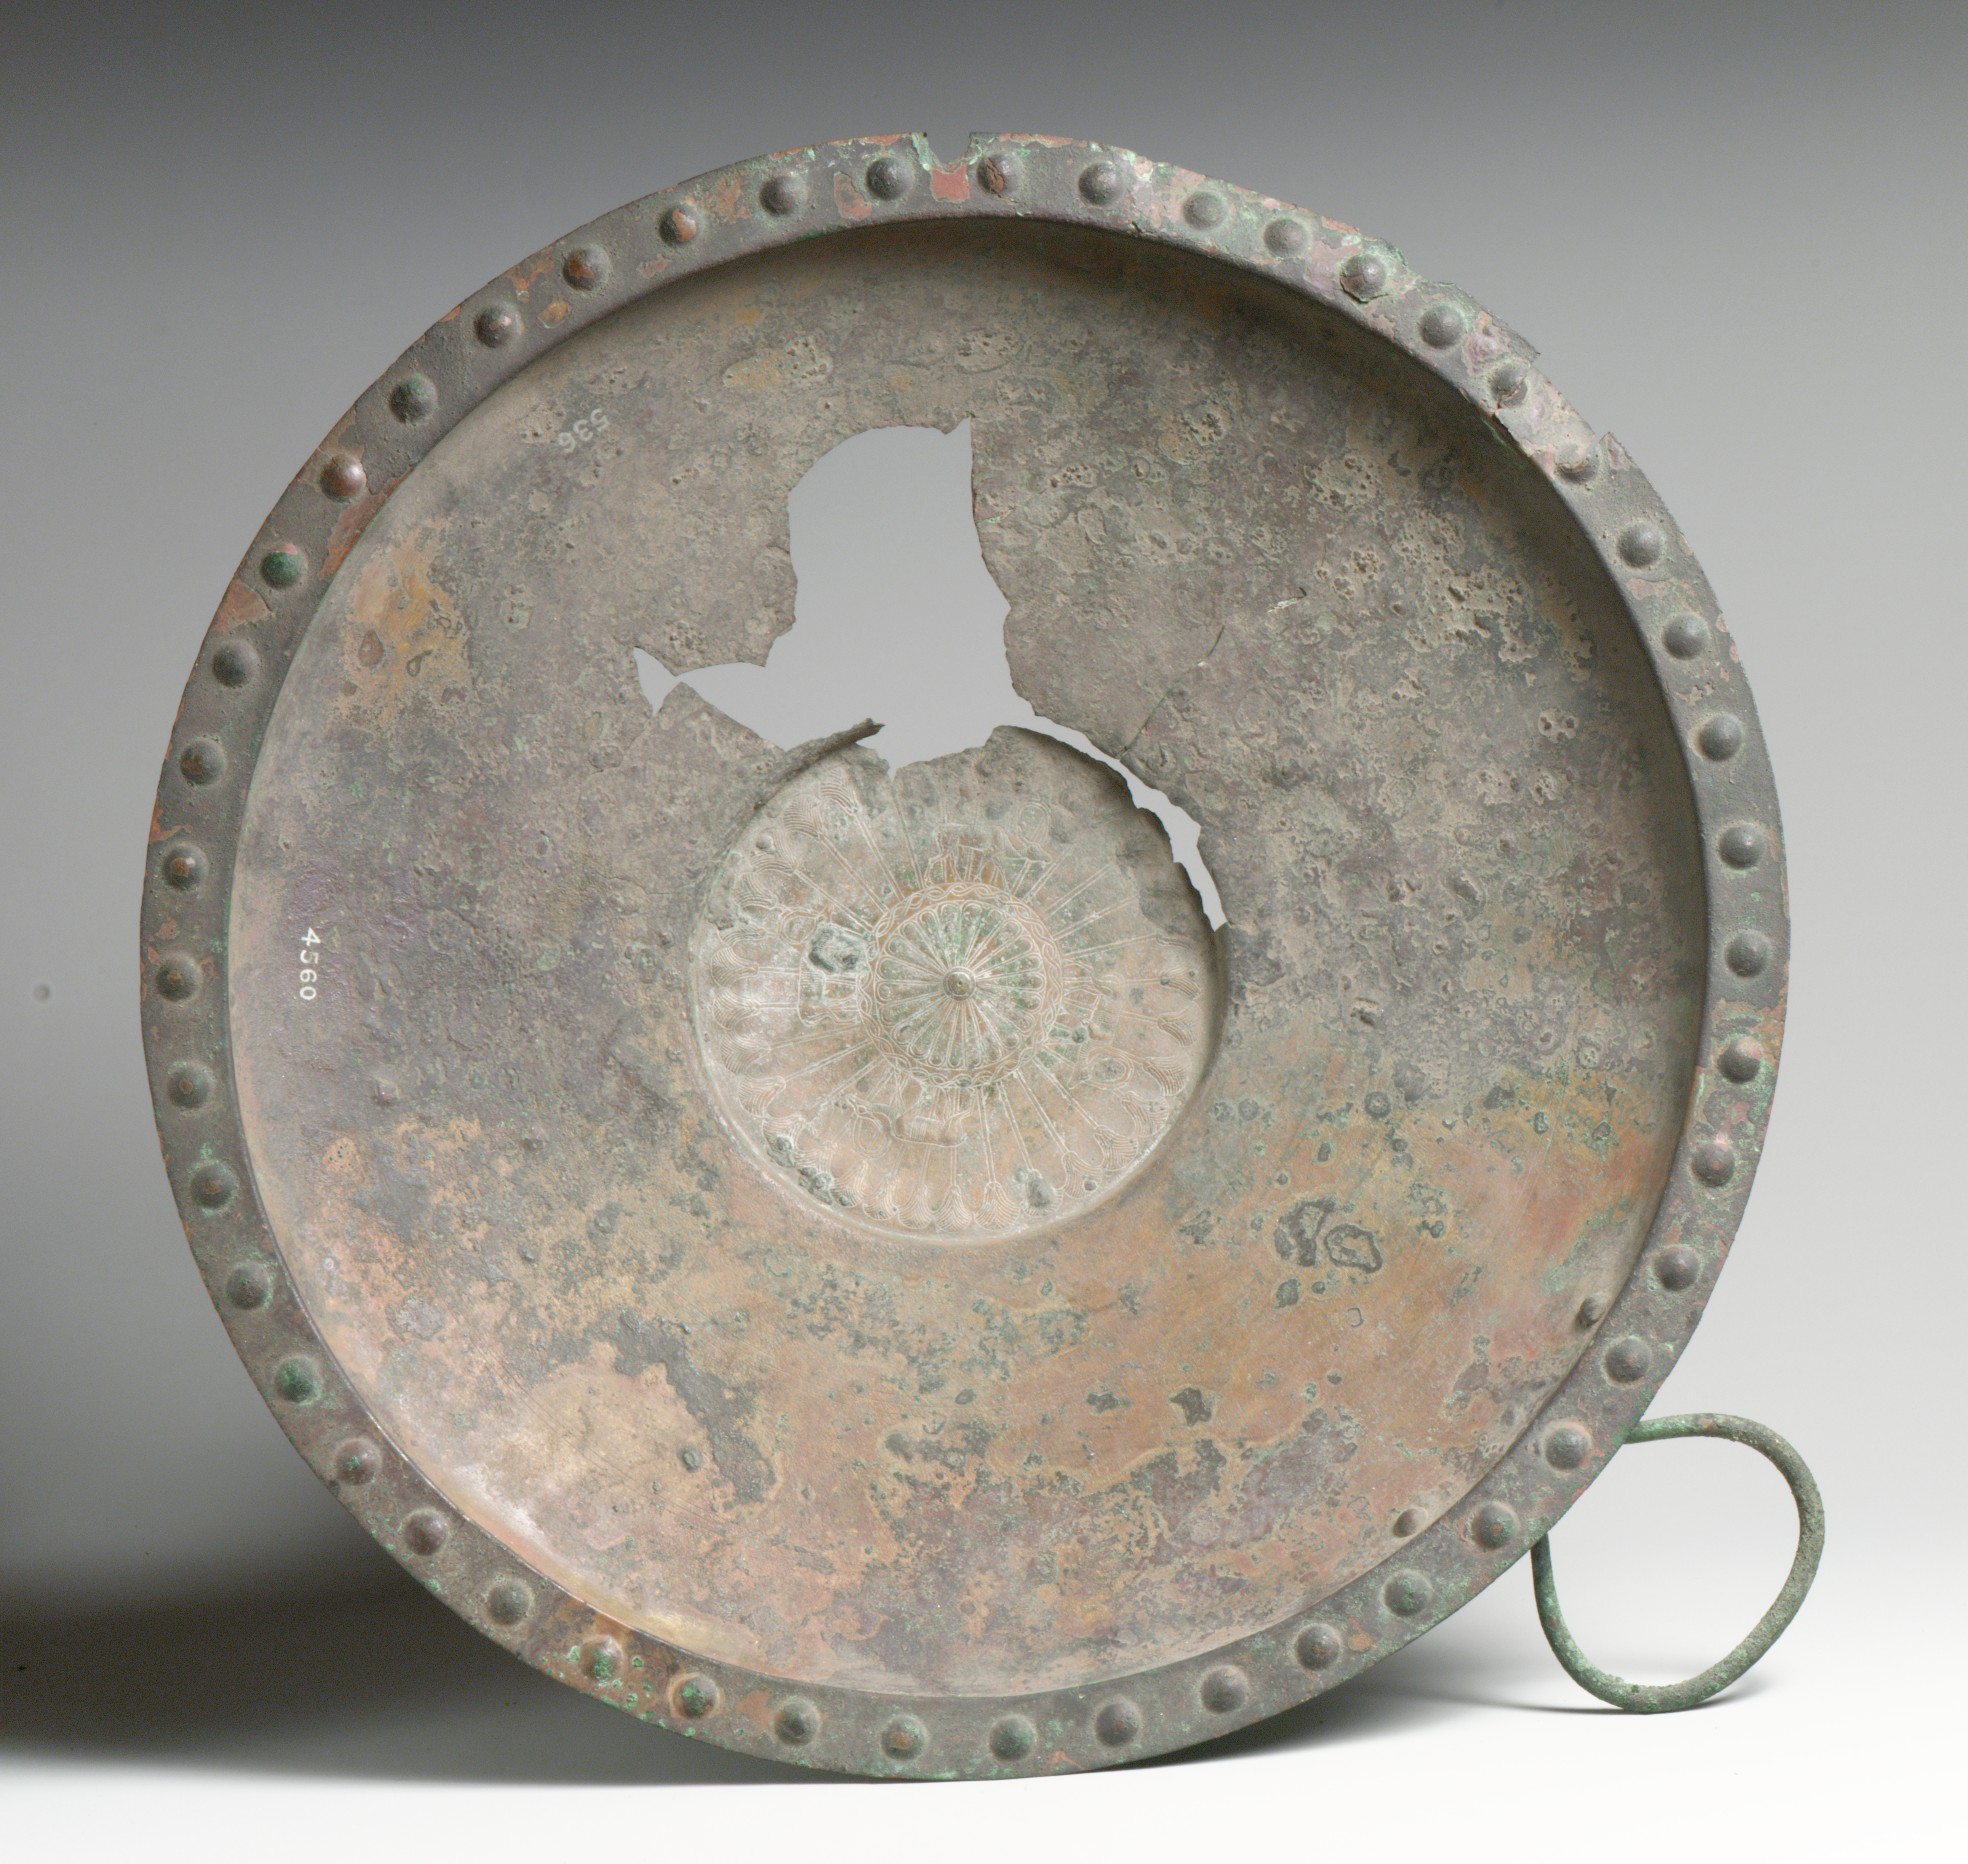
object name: bowl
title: Bronze bowl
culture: cypriot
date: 700-601 BCE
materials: bronze